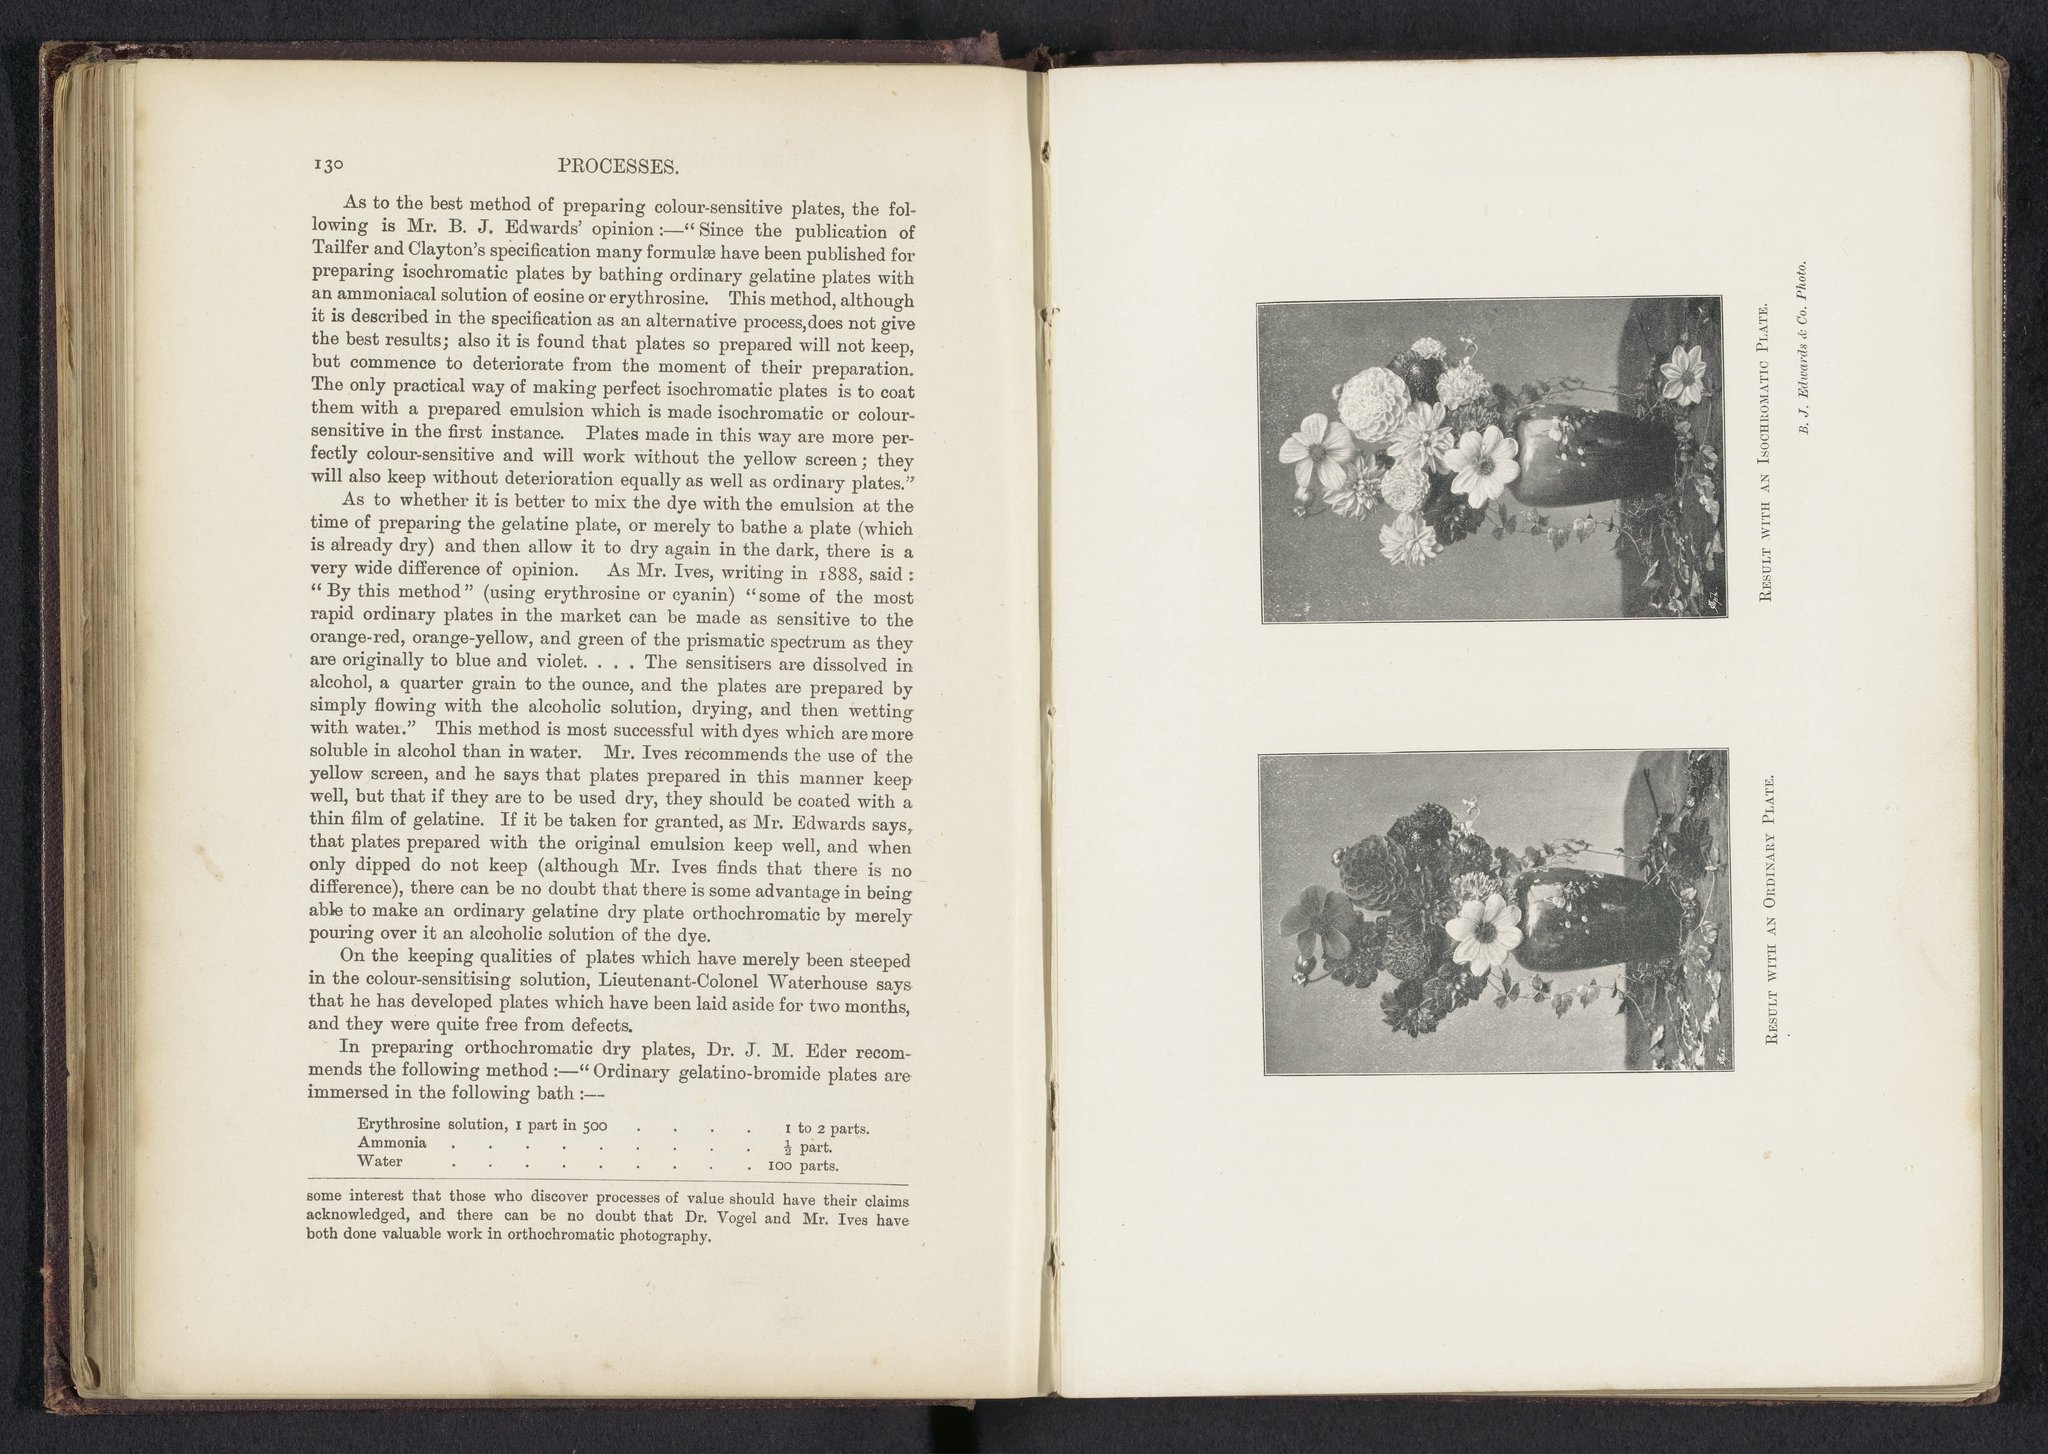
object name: photomechanical print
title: Twee vazen met bloemen, gefotografeerd met en zonder isochromatische plaat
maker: Anonymous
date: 1889-1899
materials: paper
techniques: autotype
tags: flowers in a vase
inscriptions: inscription: ‘Result with an Ordinary Plate. Result with an Isochromatic Plate.’